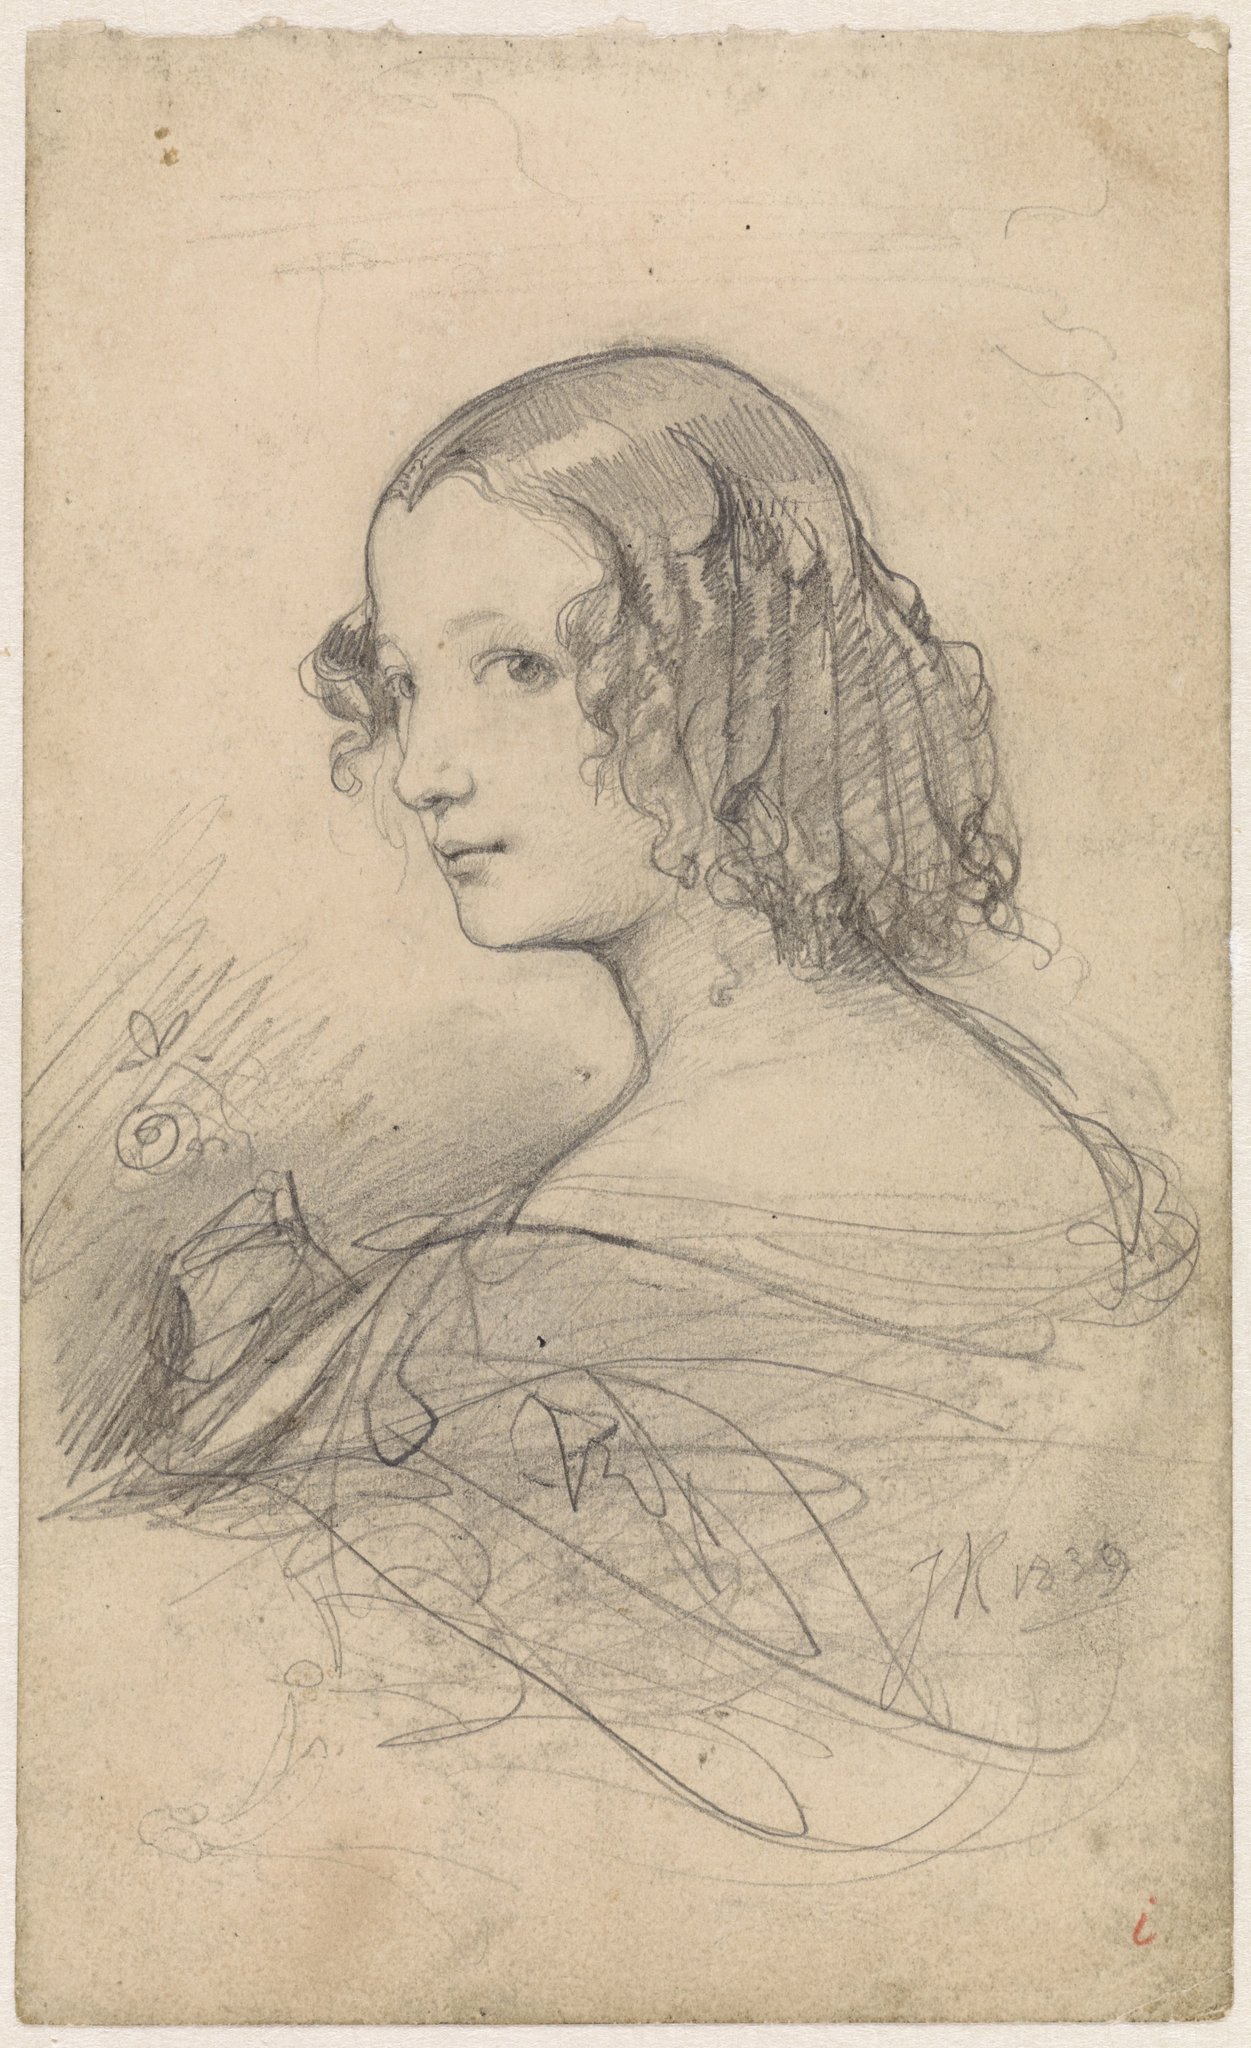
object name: drawing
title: Portret van een jonge vrouw met pijpenkrullen, naar links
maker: johan hendrik koelman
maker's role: draughtsman, print maker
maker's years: 1820-1887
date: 1839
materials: paper, pencil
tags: anonymous historical person portrayed alone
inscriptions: date: ‘1839’